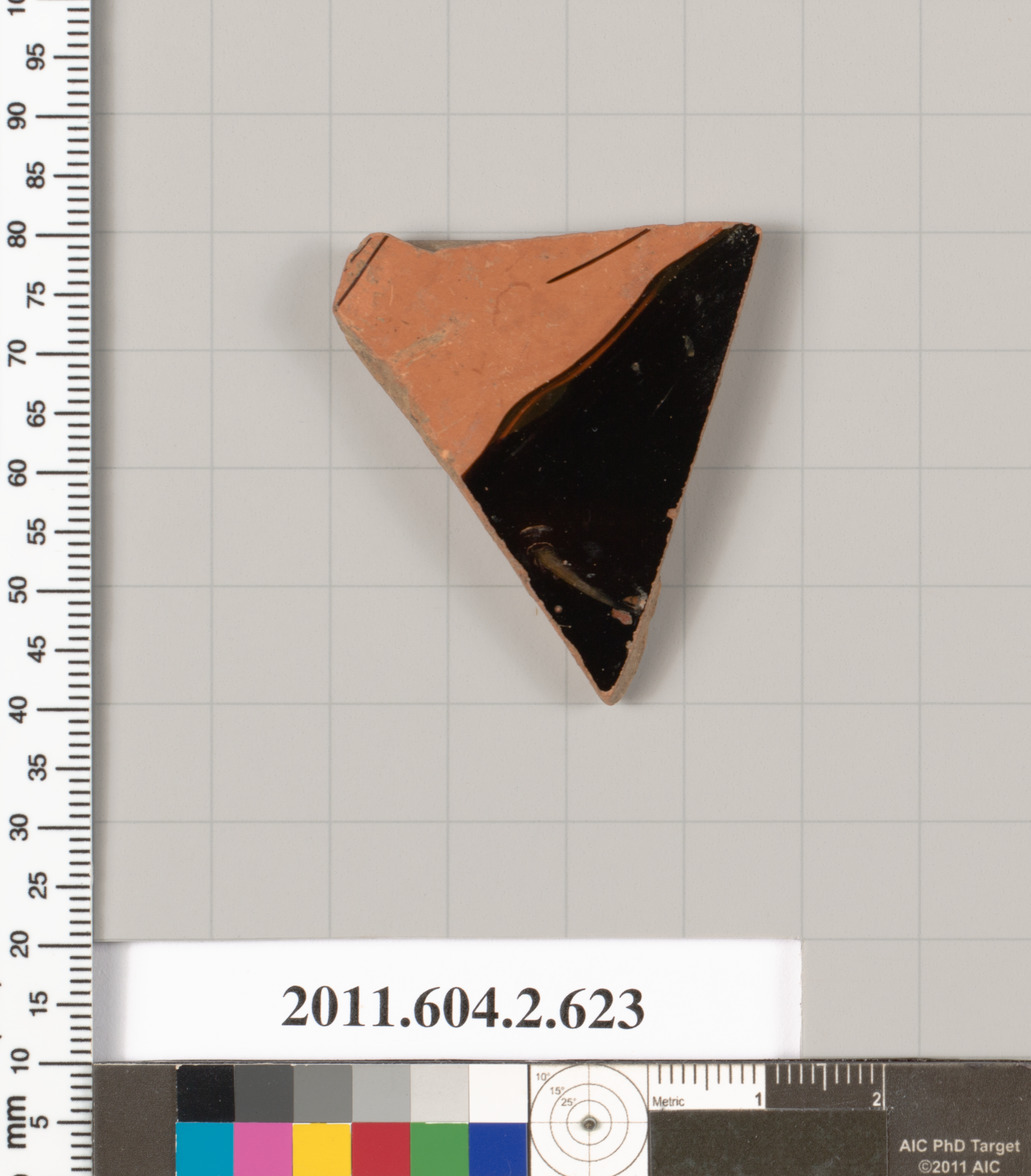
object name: column krater fragment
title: Terracotta fragment of a column-krater (bowl for mixing wine and water)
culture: greek, attic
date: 475-451 BCE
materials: terracotta